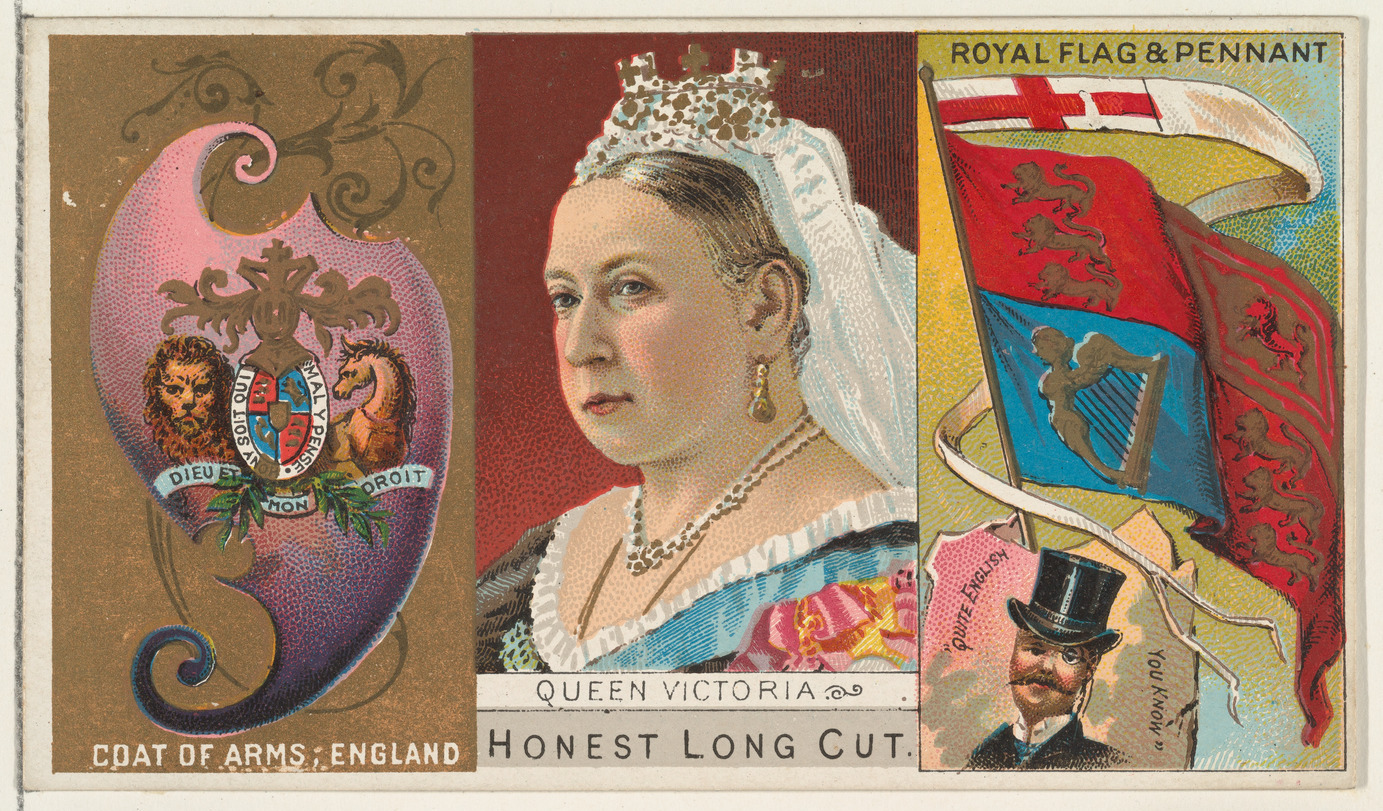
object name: print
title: Queen Victoria of England, from the Rulers, Flags, and Coats of Arms series (N126-1) issued by W. Duke, Sons & Co.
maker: w. duke, sons & co.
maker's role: publisher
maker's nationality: american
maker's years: 1870-1920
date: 1888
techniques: color lithograph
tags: coat of arms,flags,queen victoria